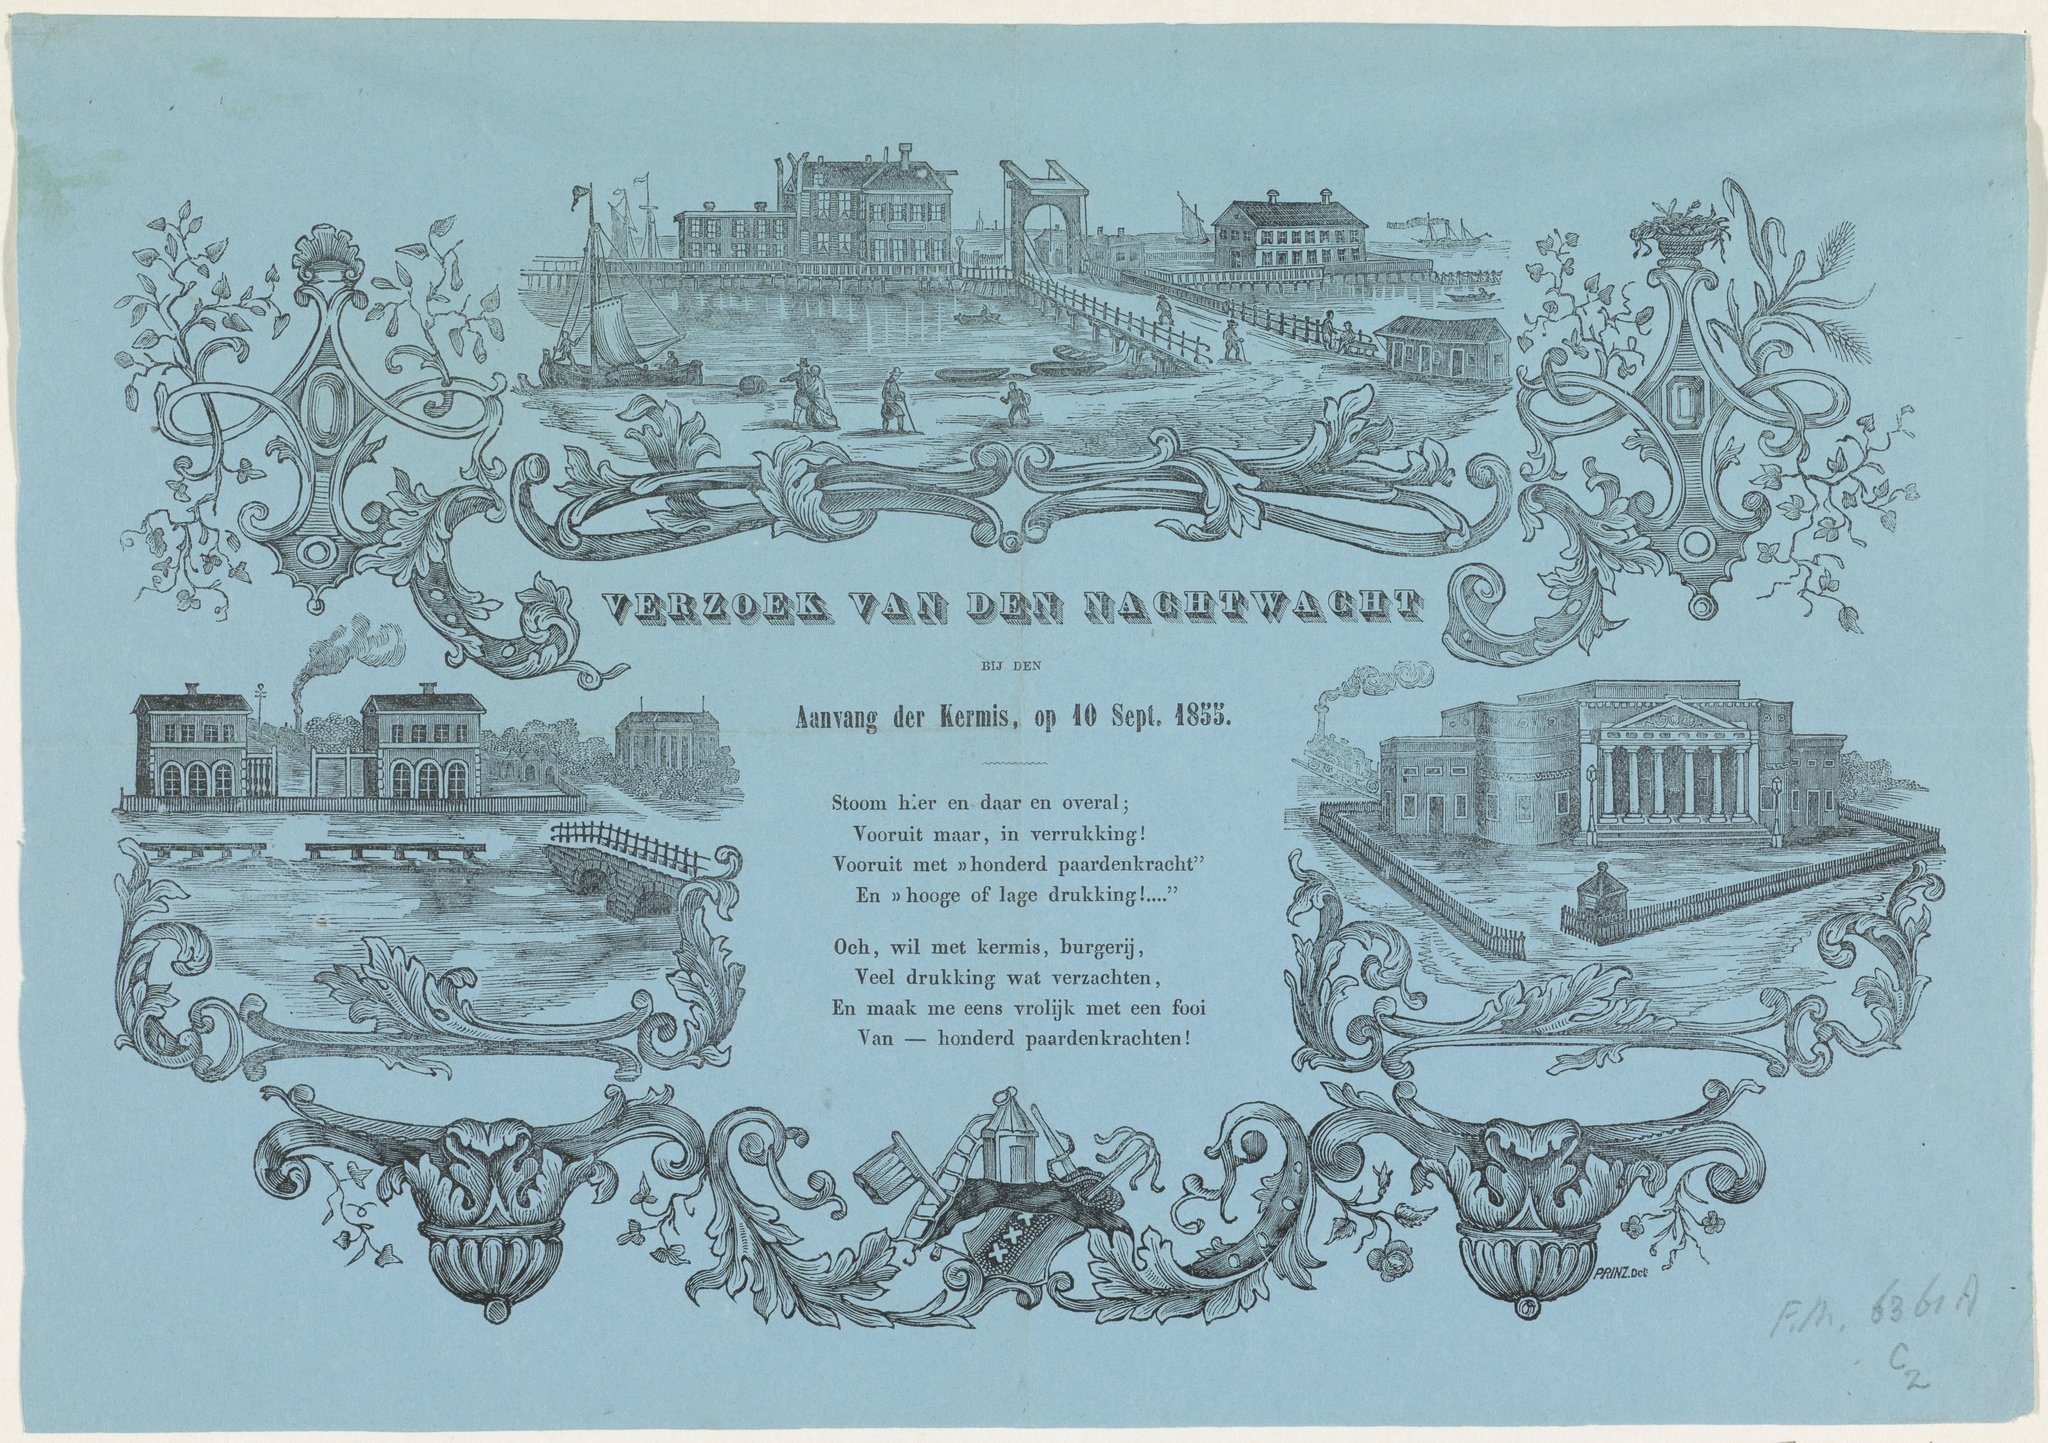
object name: print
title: Kermisprent van de Amsterdamse nachtwacht voor het jaar 1855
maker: friedrich robert prinz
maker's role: print maker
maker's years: 1820-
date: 1855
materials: paper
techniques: letterpress printing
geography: netherlands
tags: night patrol, railway, train (+ propulsion of vehicle, ship, etc. by steam), station; shelter (railway, tramway), amsterdam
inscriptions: collector's mark: Lugt 2228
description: Kermisprent van de Amsterdamse nachtwacht (ratelwacht), 10 september 1855. Drie voorstellingen van gebouwen in verband met stoomkracht: de Nieuwe Stadsherberg, de Weesperpoortstation en het Station Amsterdam Willemspoort van de Nederlandsche Rhijnspoorweg-Maatschappij. Centraal een gedicht in twee verzen.